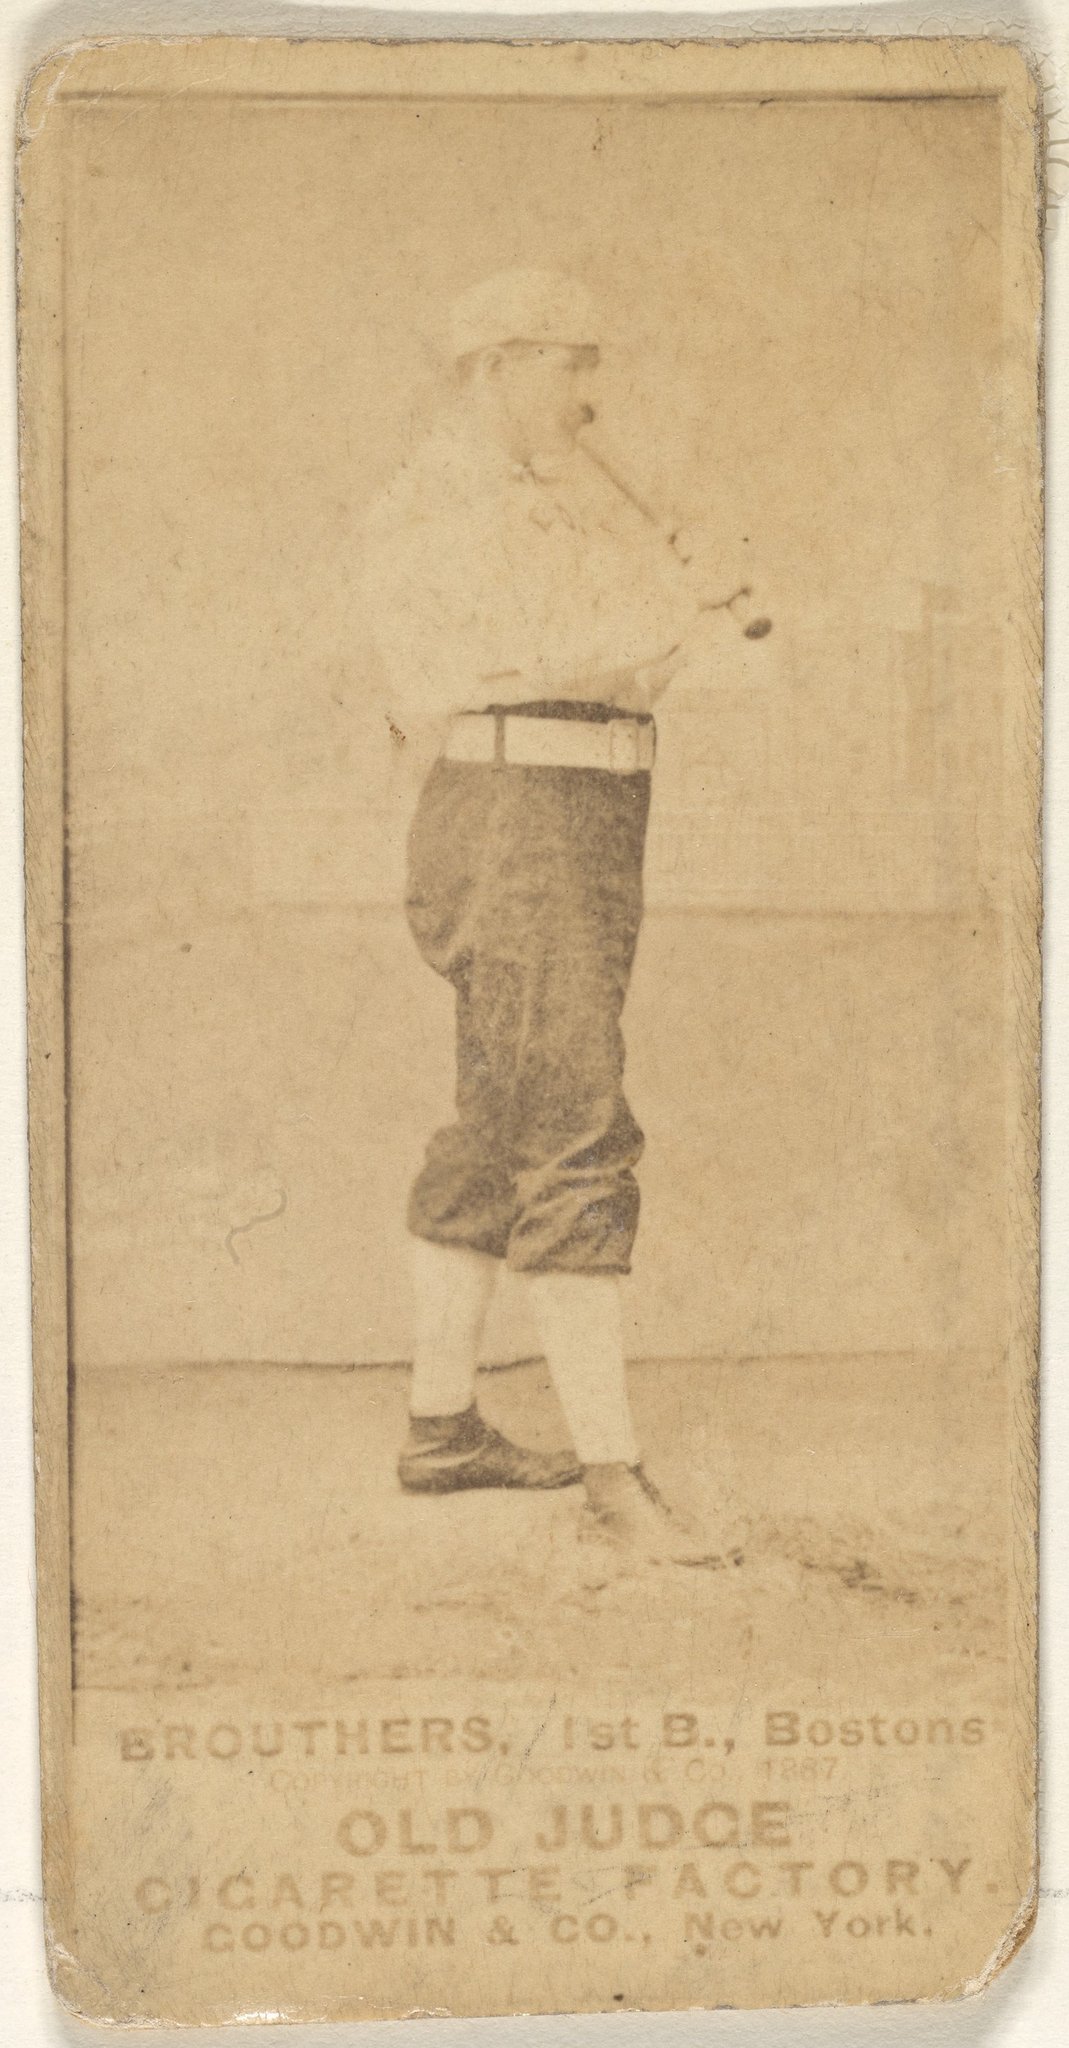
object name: baseball card, photograph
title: Brouthers, 1st Base, Boston, from the Old Judge series (N172) for Old Judge Cigarettes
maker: goodwin & company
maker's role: publisher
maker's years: 1850-1950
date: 1887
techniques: albumen silver print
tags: men,portraits,baseball,athletes